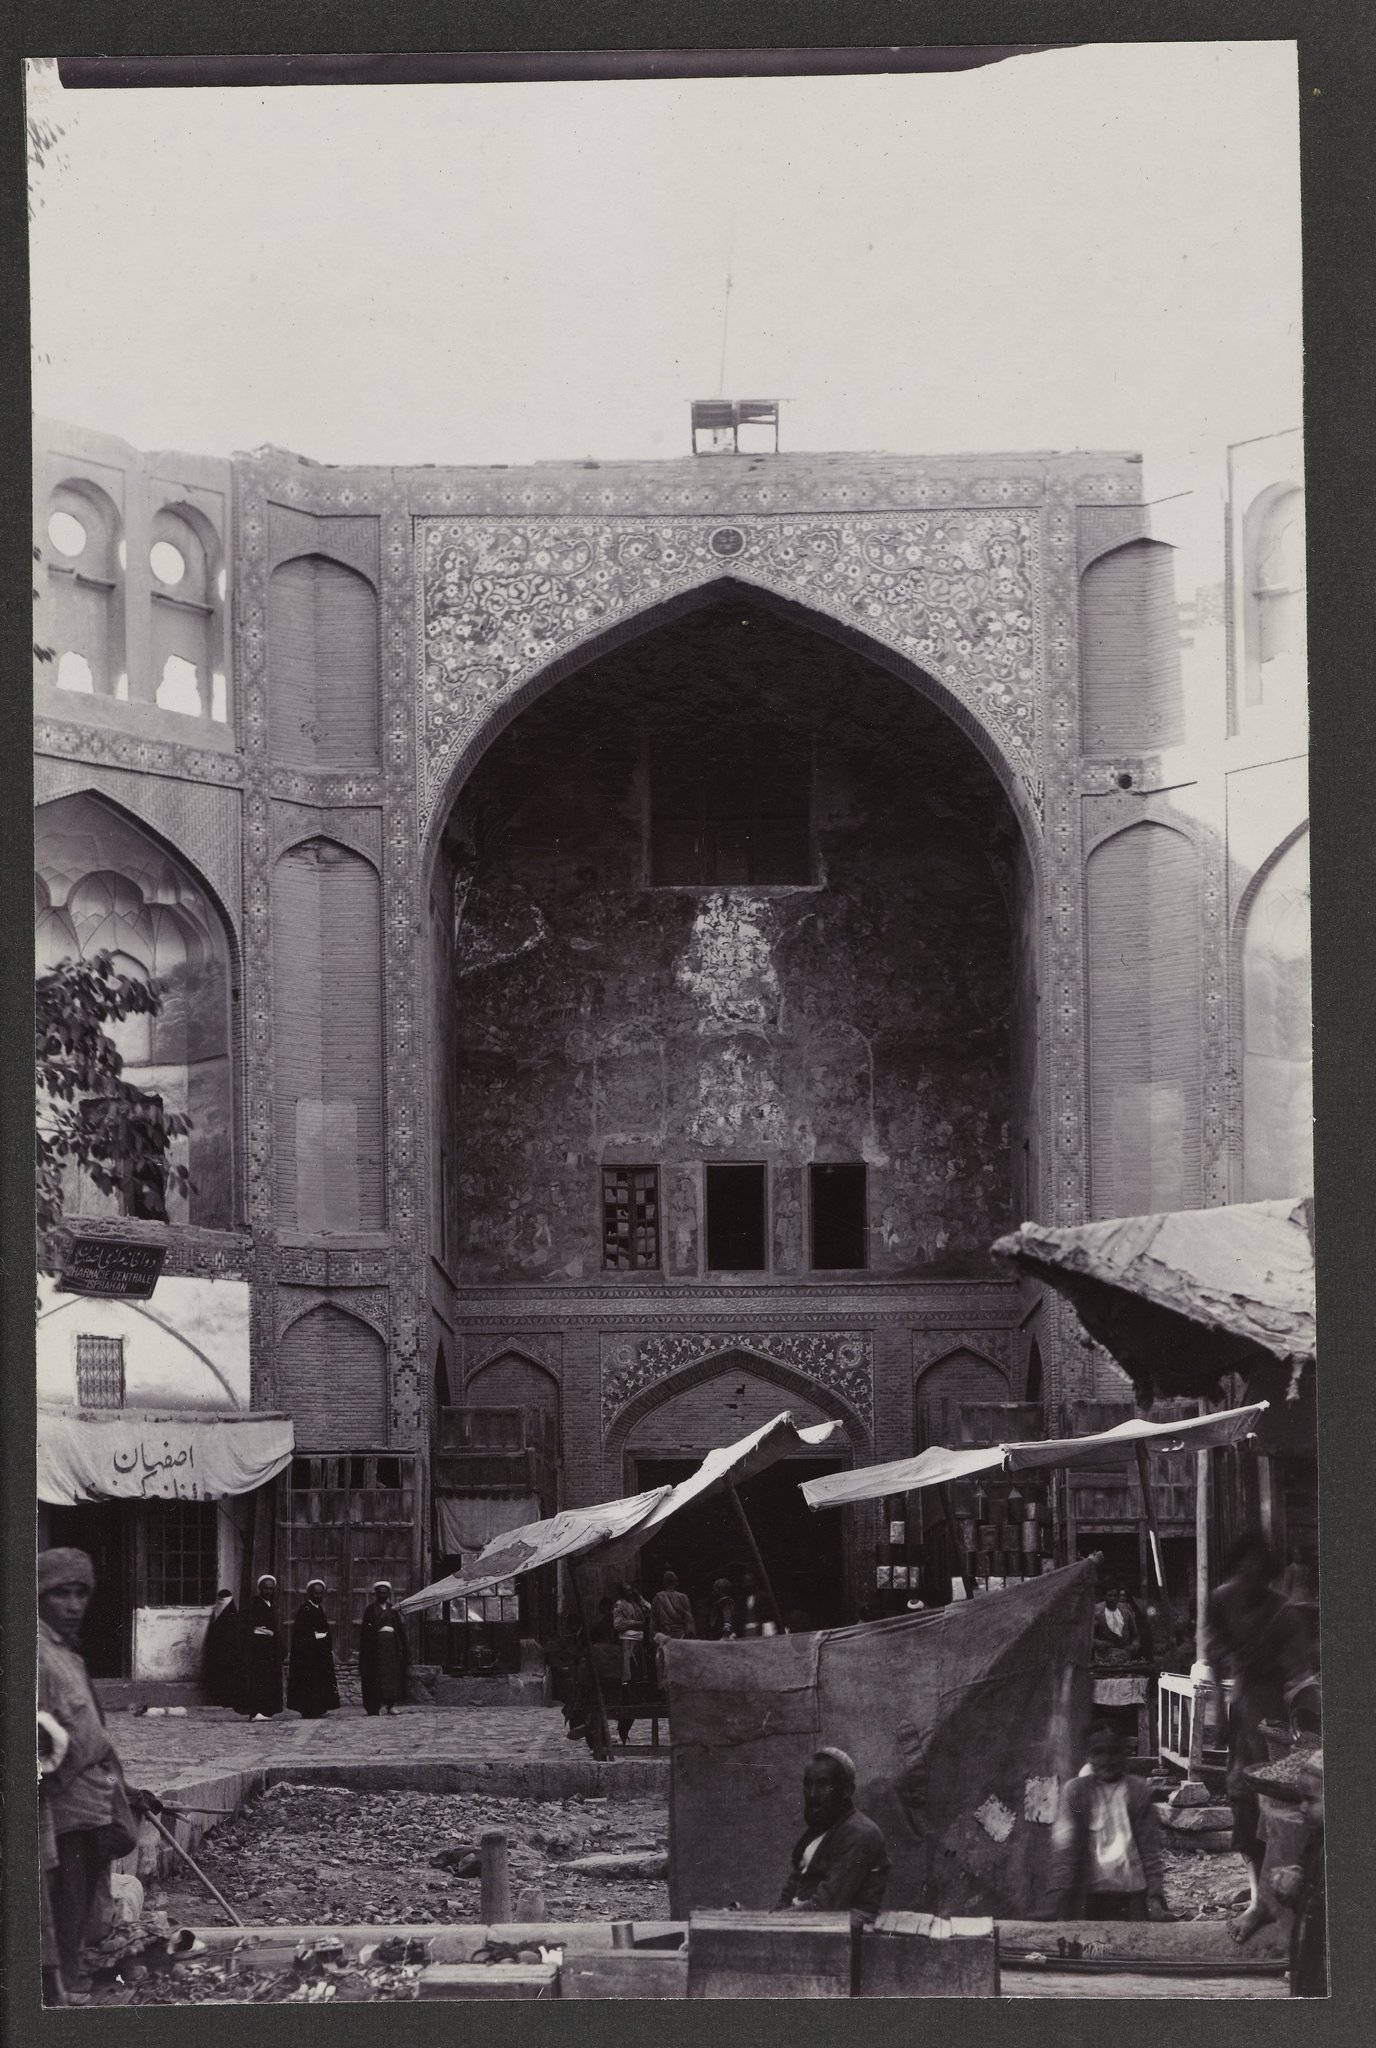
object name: photograph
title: Moskee van de Sjah (Masjed-e Shah) in Isfahan, Perzië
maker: a.g.a. van eelde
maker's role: engineer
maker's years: 1862-1950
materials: cardboard, paper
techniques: gelatin silver print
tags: isfahan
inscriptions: number: ‘47.’